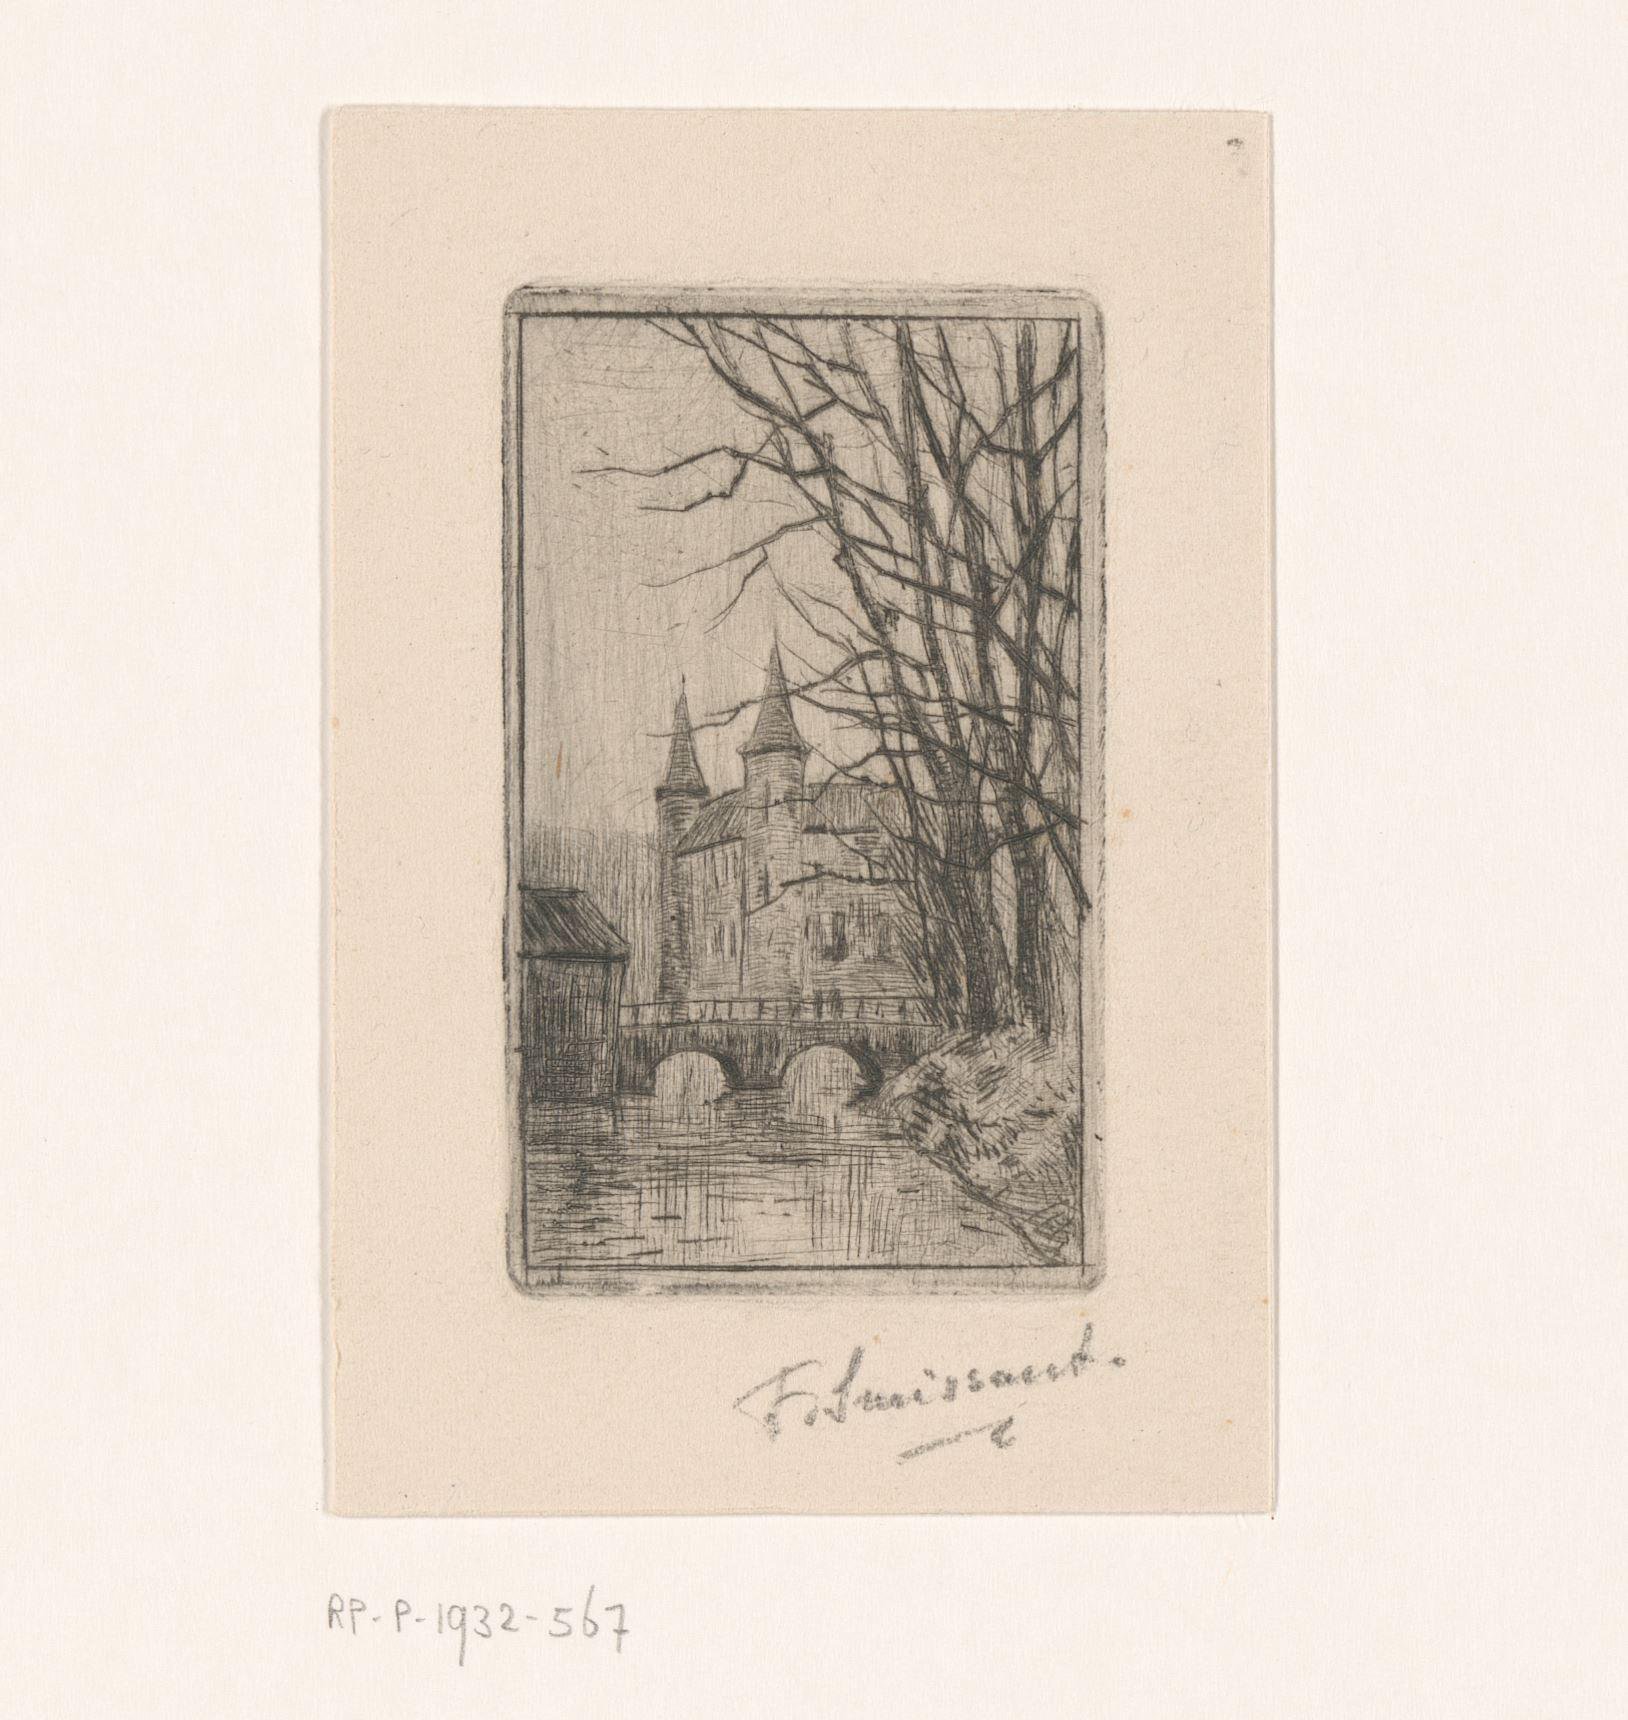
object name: print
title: Kasteel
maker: frans smissaert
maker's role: draughtsman, print maker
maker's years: 1862-1944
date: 1872-1932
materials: paper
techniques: etching, intaglio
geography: netherlands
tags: castle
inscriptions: collector's mark: Lugt 2228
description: Gezicht op een kasteel achter een brug. Rechts staat een boomgroep op de oever.